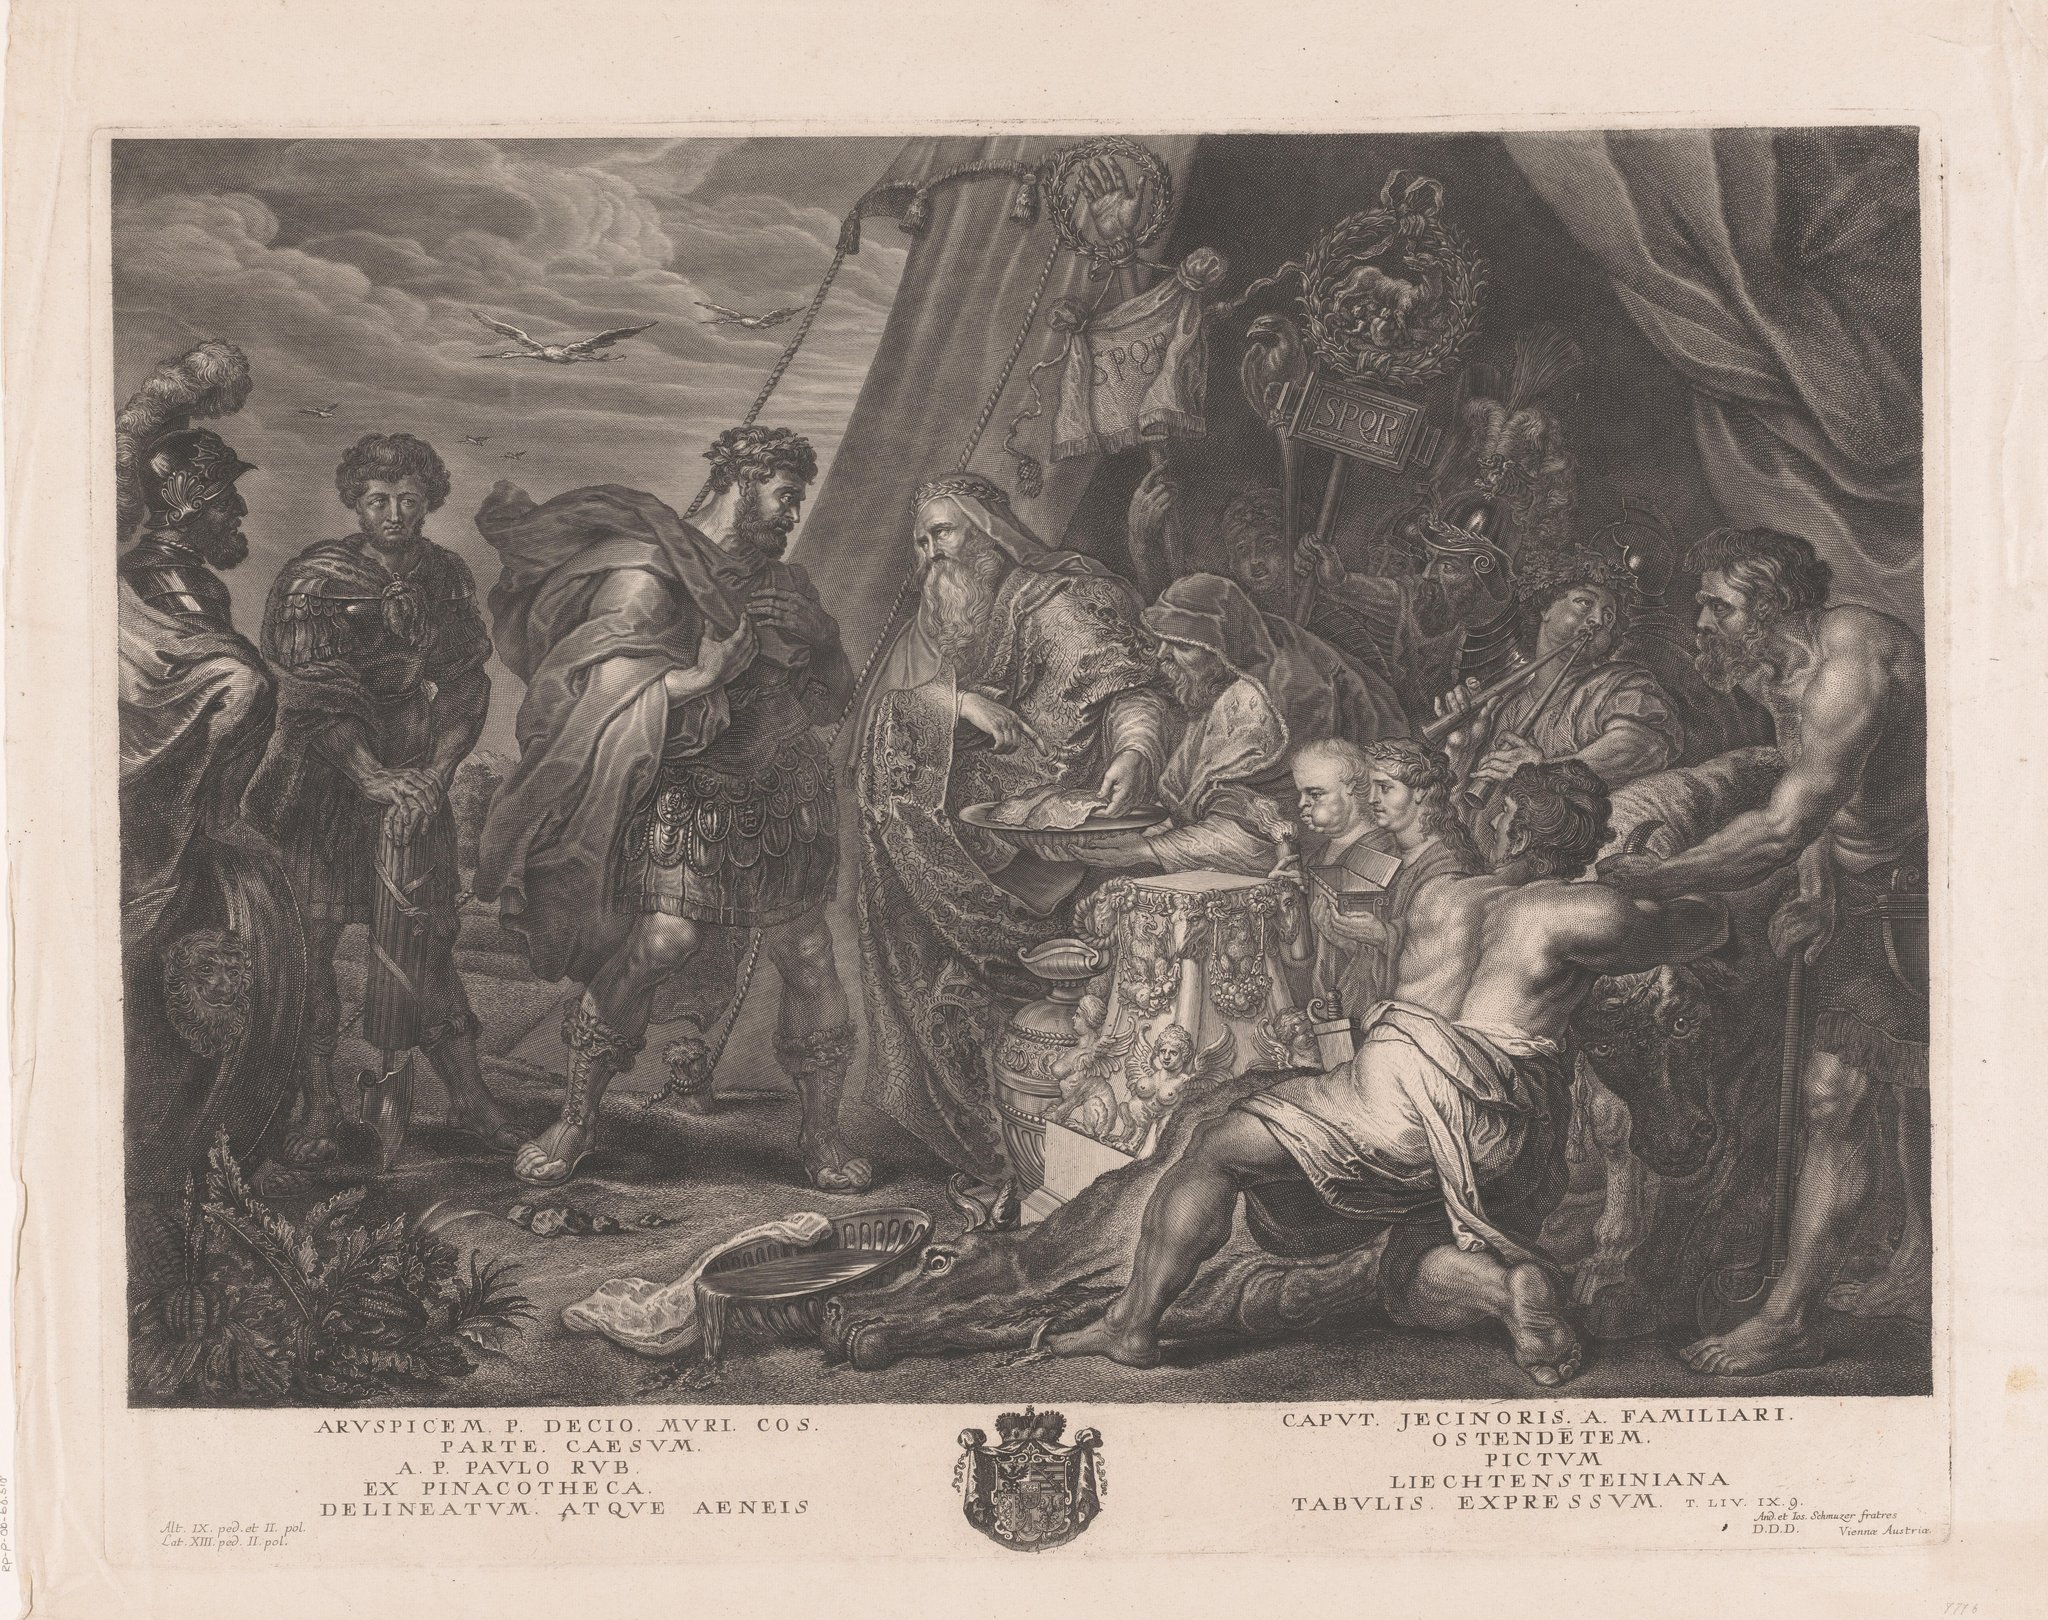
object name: print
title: Decius Mus bij de uitlegging van de haruspices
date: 1710-1740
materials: paper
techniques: engraving, etching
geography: vienna state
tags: armorial bearing, heraldry, (story of) decius mus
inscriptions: collector's mark: Lugt 240